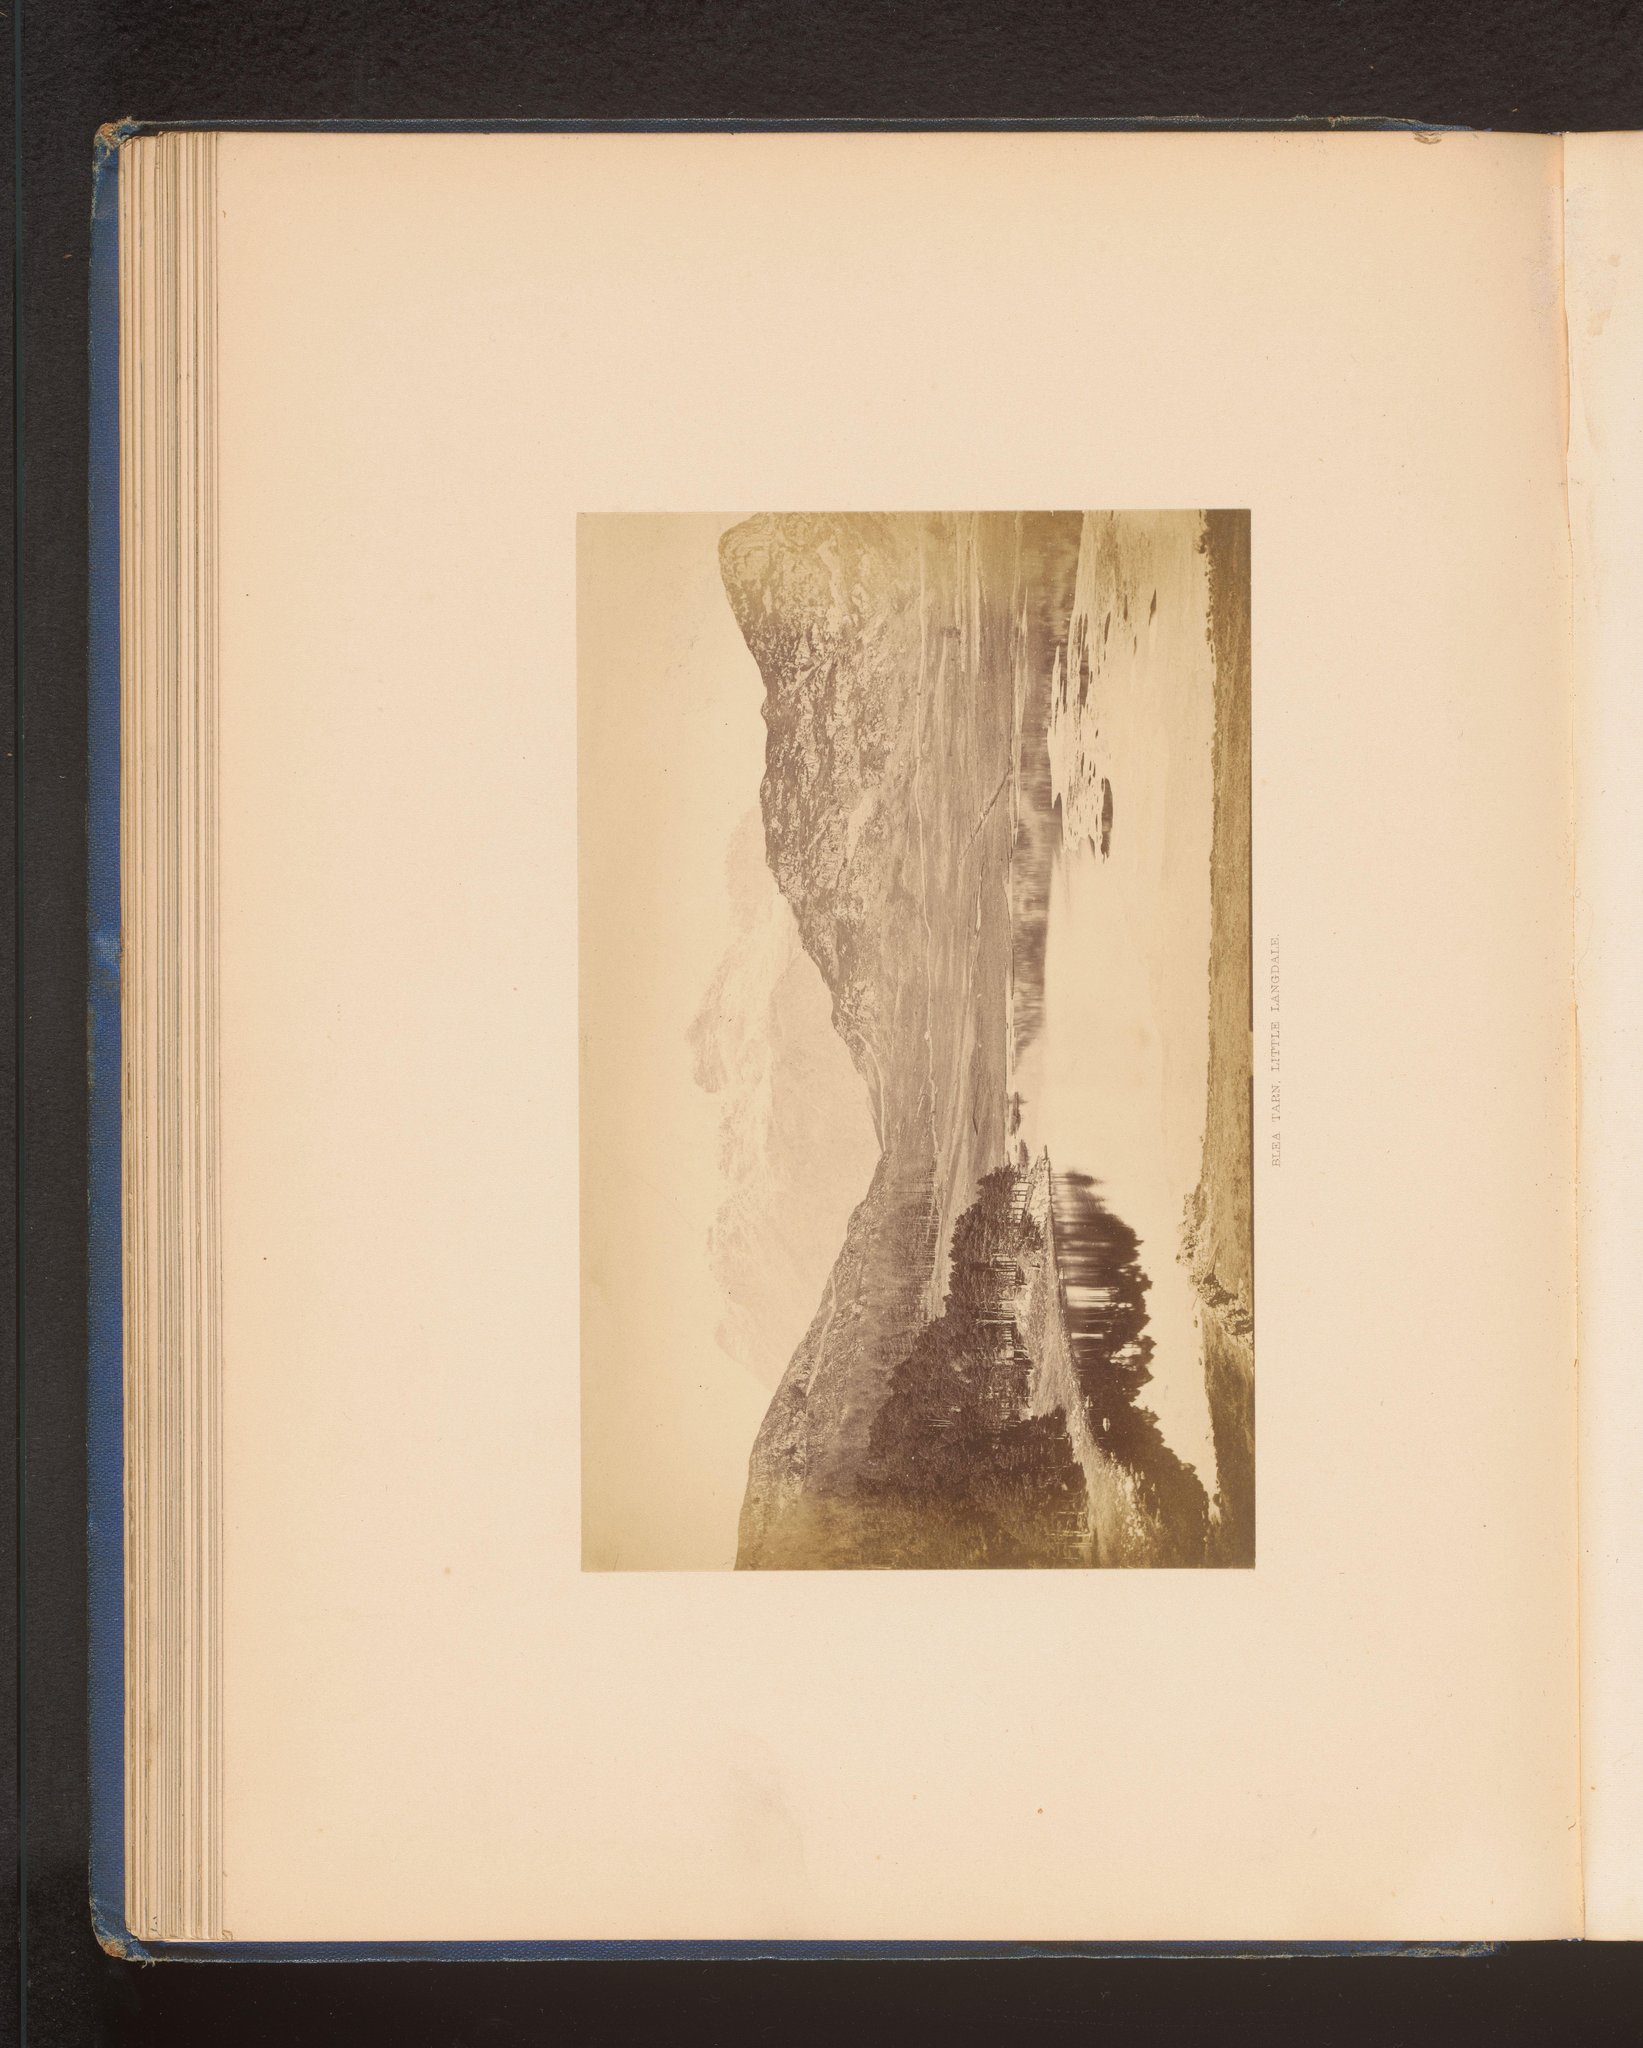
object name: page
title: Gezicht op Little Langdale met het meer Blea Tarn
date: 1857-1867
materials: photographic support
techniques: albumen print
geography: lake district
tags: dale, valley, lake